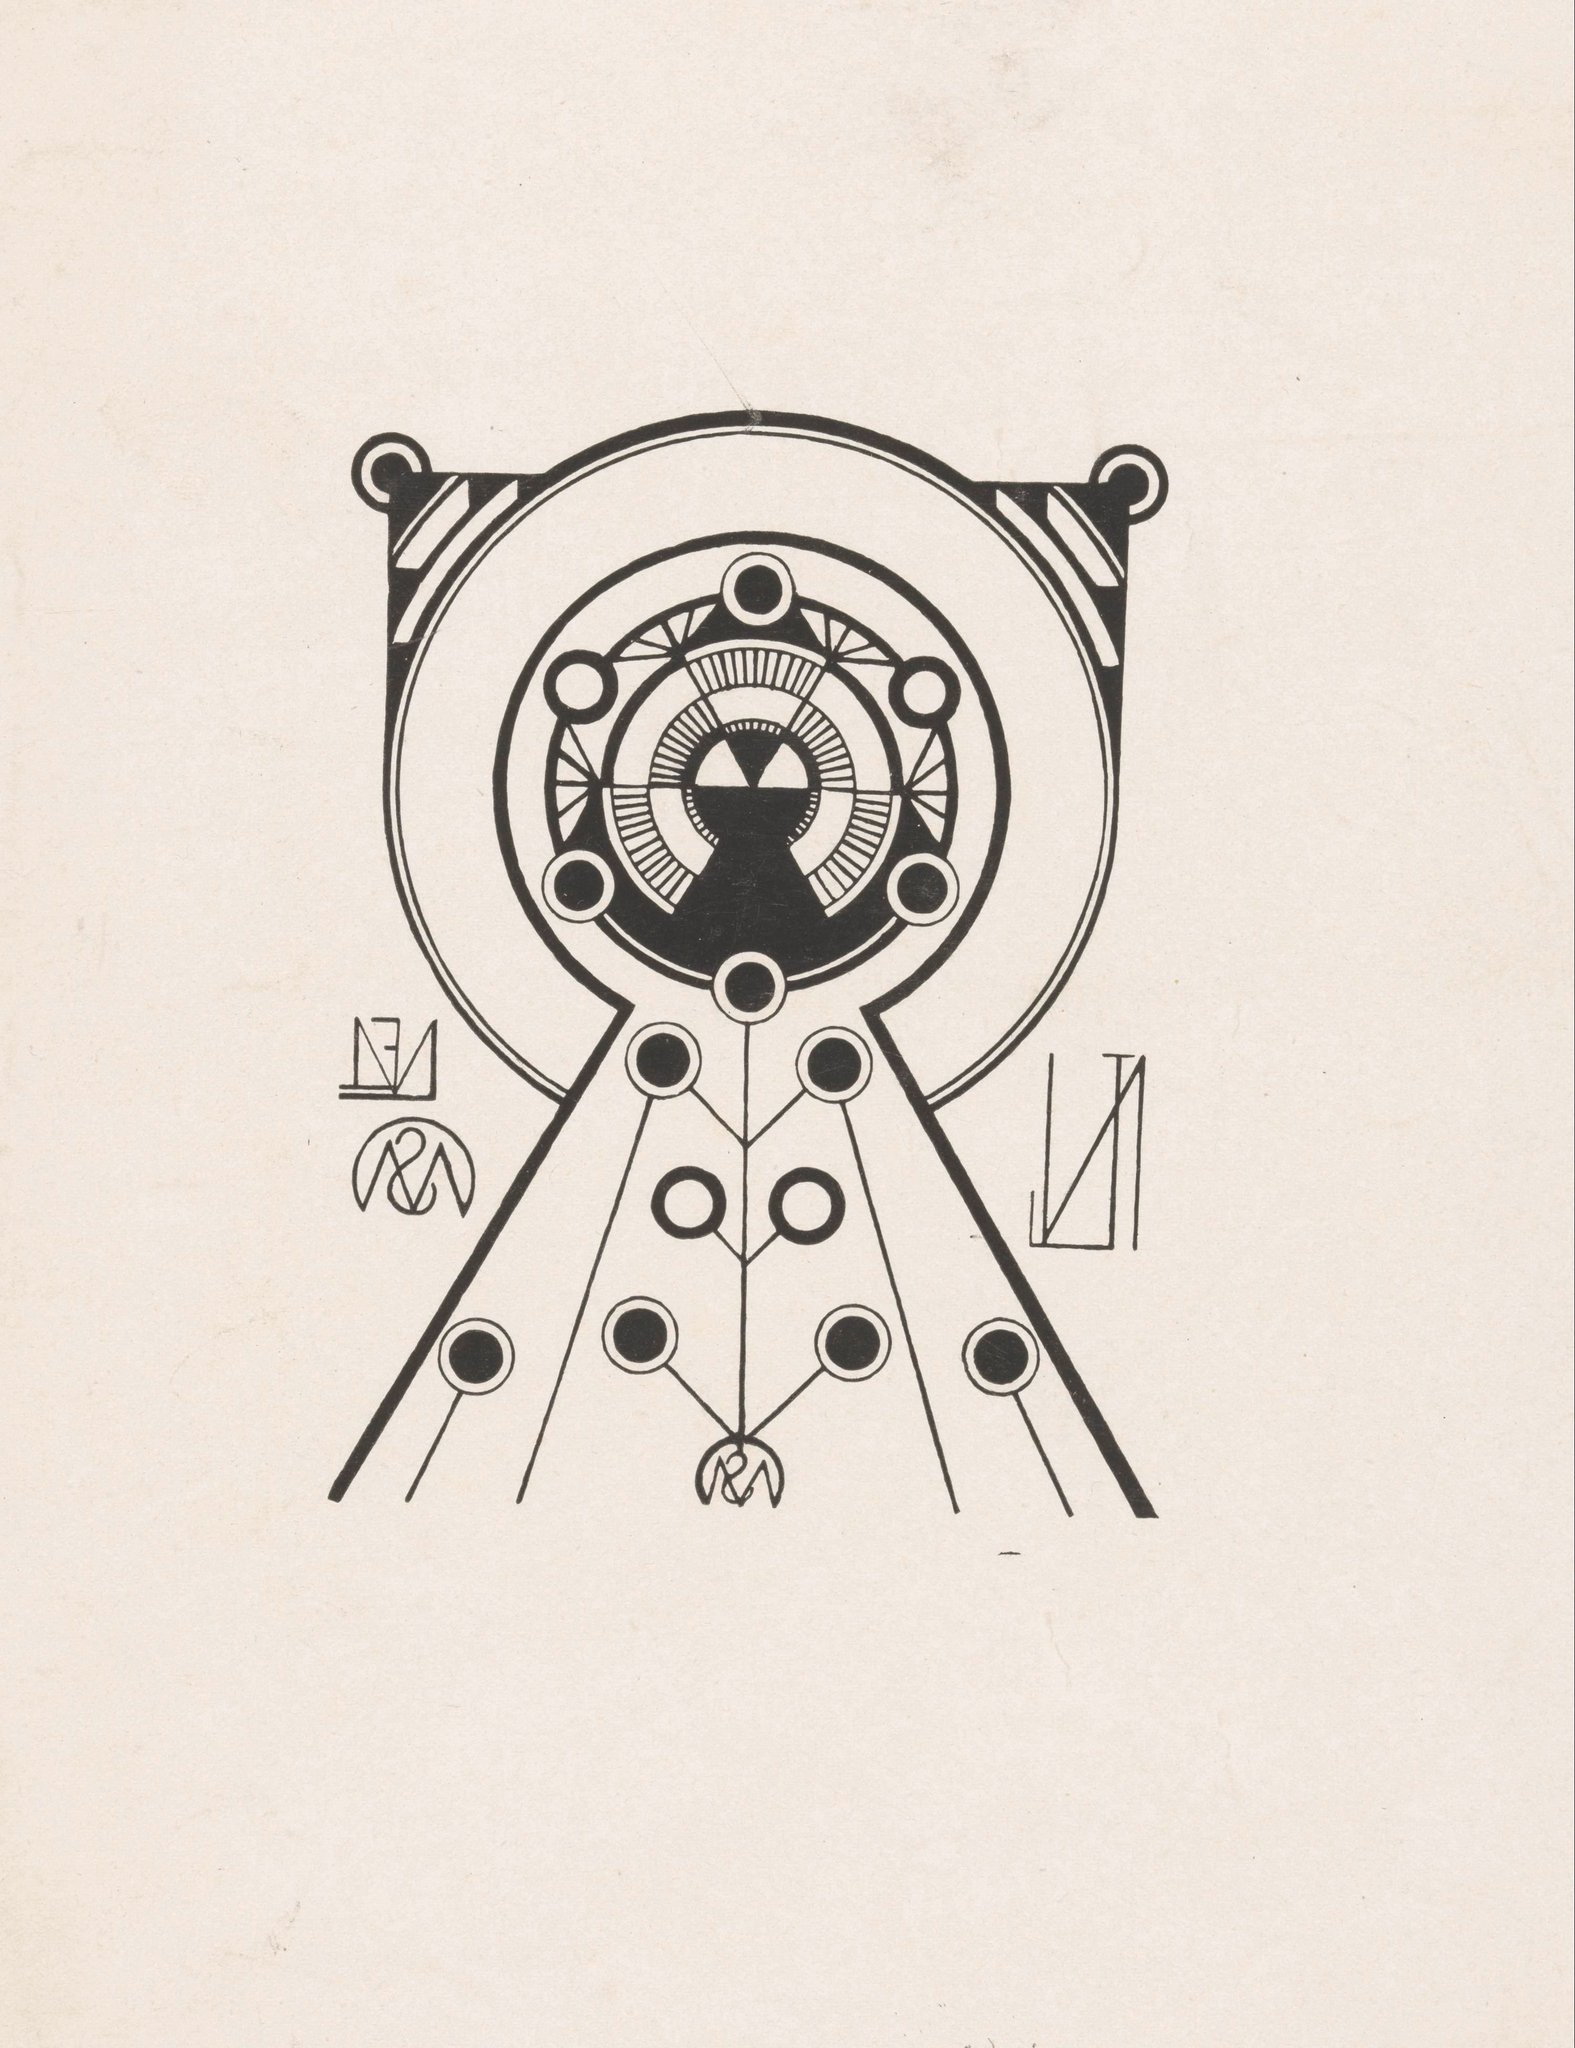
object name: print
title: Ex libris van JFN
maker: samuel jessurun de mesquita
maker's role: draughtsman, print maker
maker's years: 1868-1944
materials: paper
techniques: letterpress printing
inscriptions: collector's mark: Lugt 2228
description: Abstracte compositie in de vorm van een sleutelgat. In het midden een cirkel met daarin een ster; onderaan zeven cirkels. Links en rechts een monogram JFN.